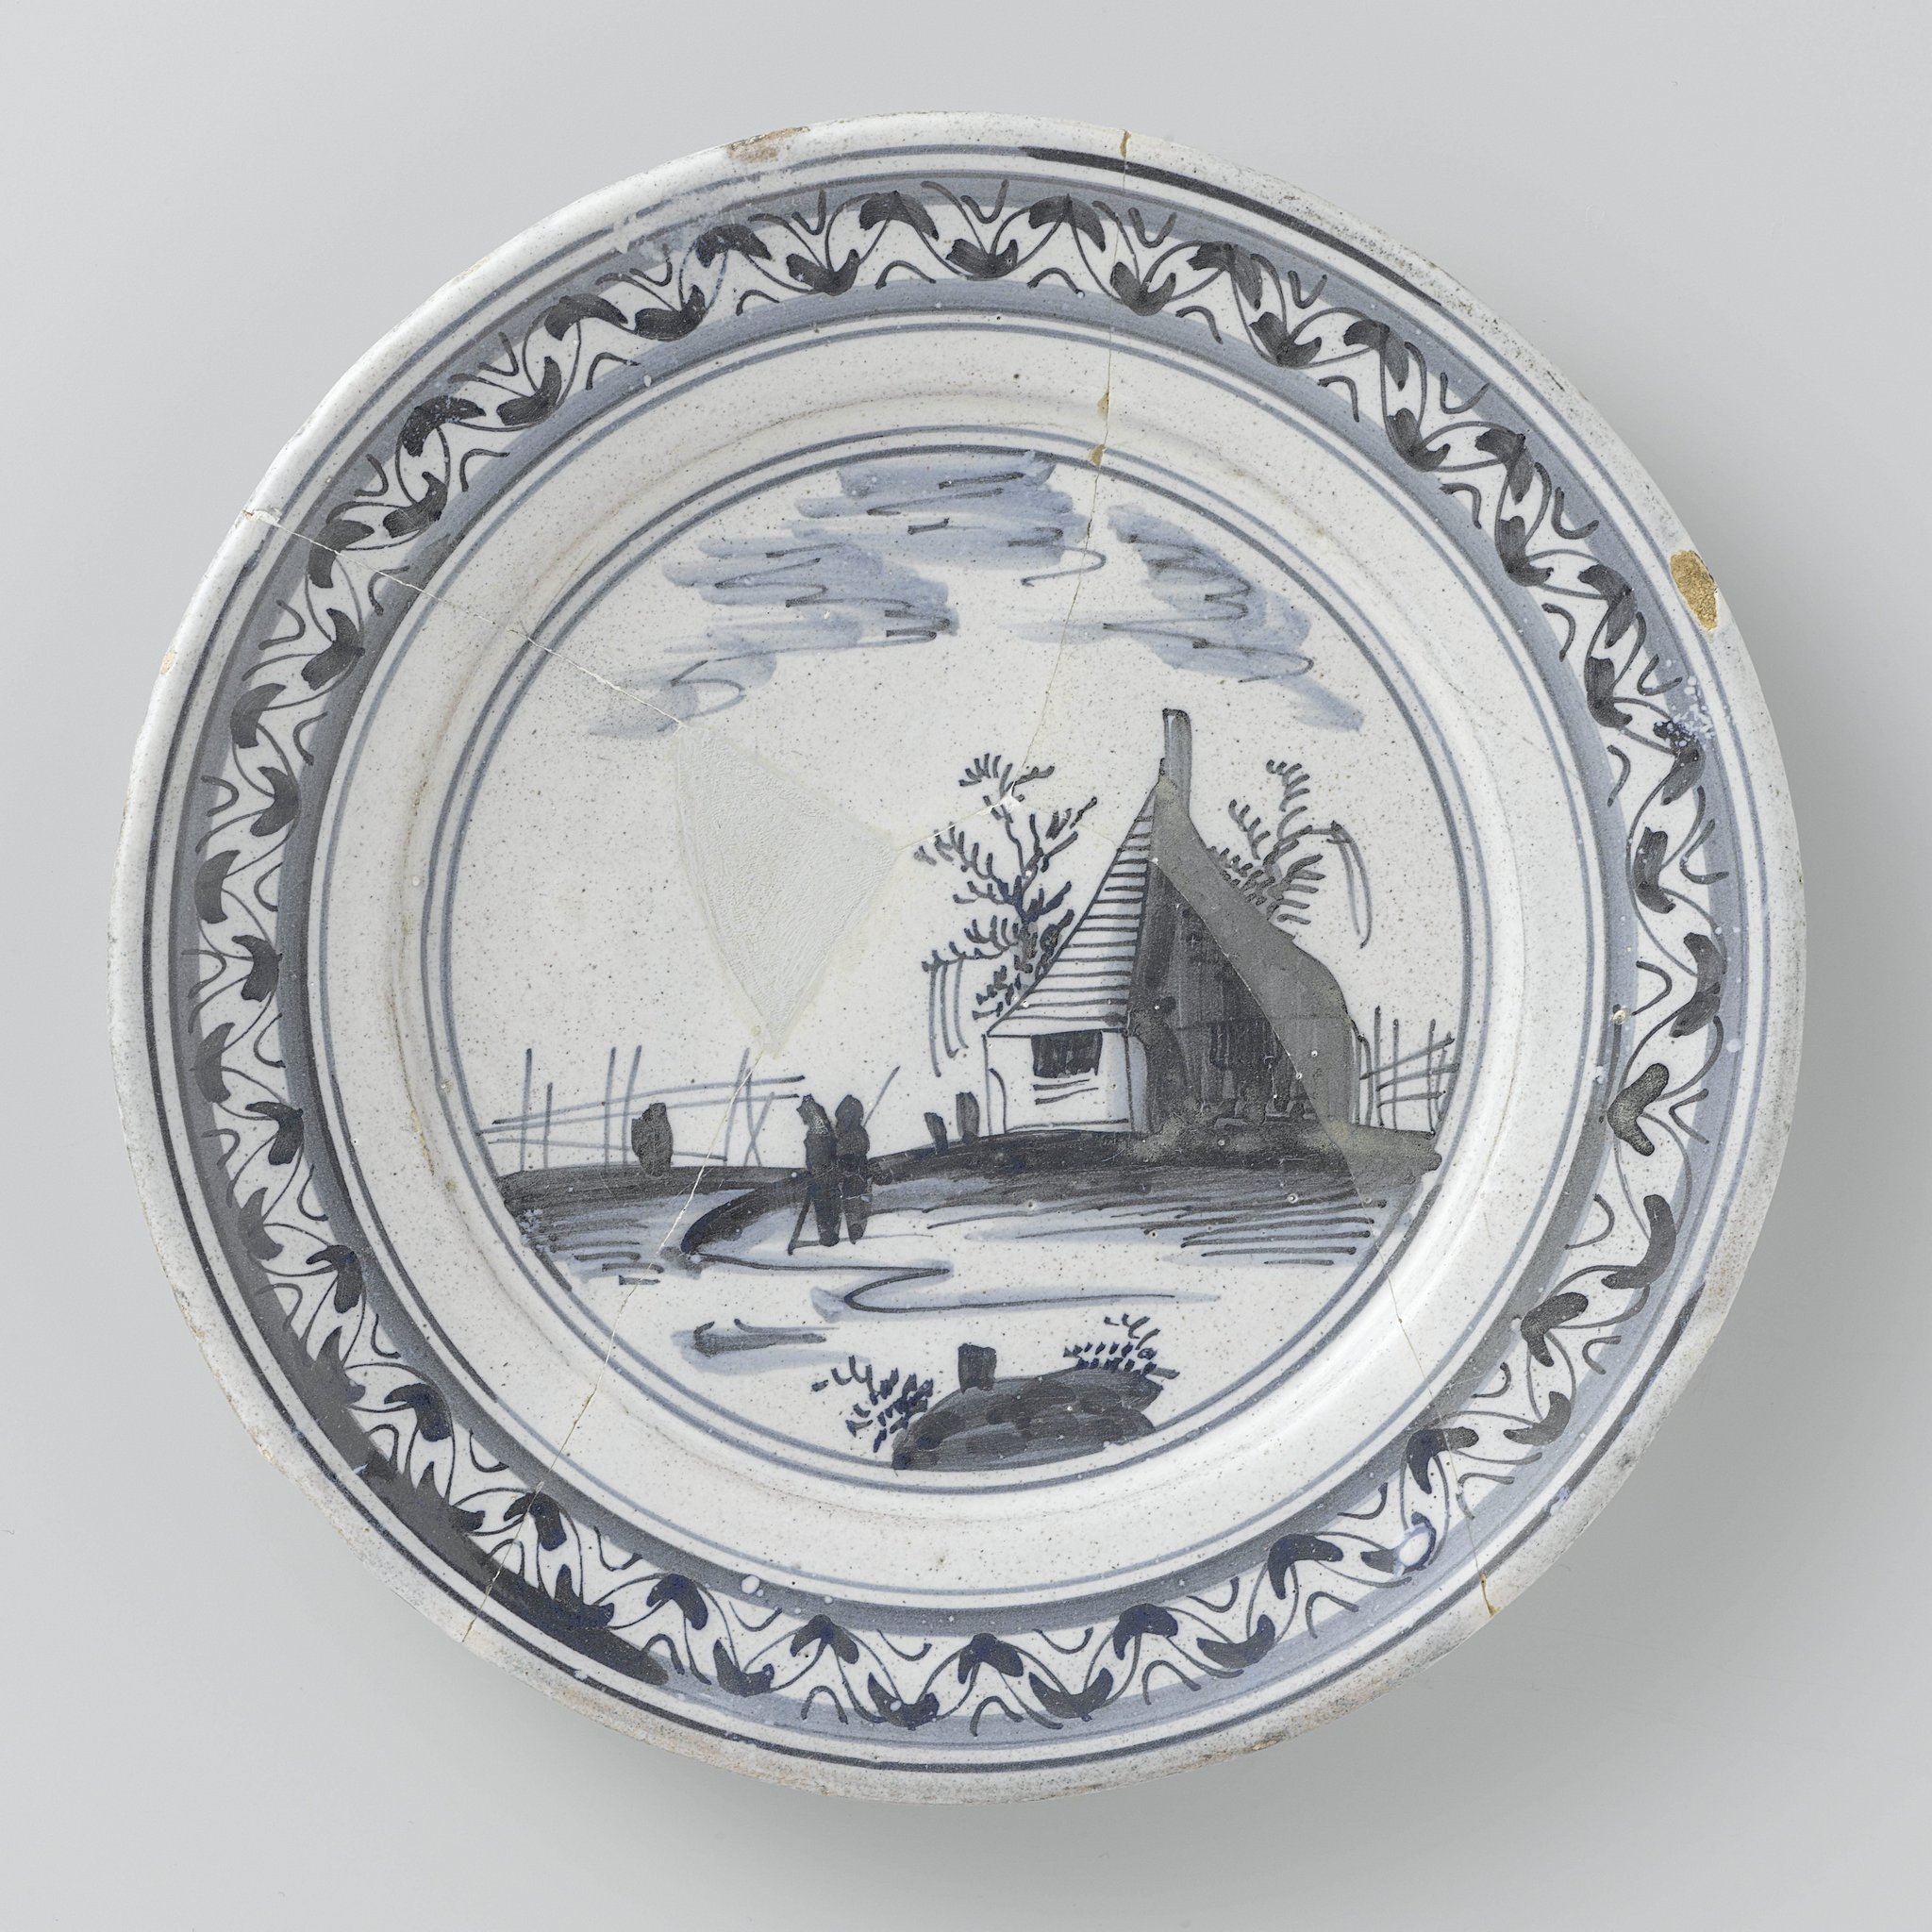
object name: plate dish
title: Bord met op het plat in blauw een landschap met huis en figuren; op de rand een bladfries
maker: Anonymous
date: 1635-1650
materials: earthenware, glaze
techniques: painted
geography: delft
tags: delft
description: Rond bord van blauw beschilderde faience. Op het plat is een landschap met een huis en figuren geschilderd en op de rand een bladfries. Het bord is een bodemvondst uit Delft.